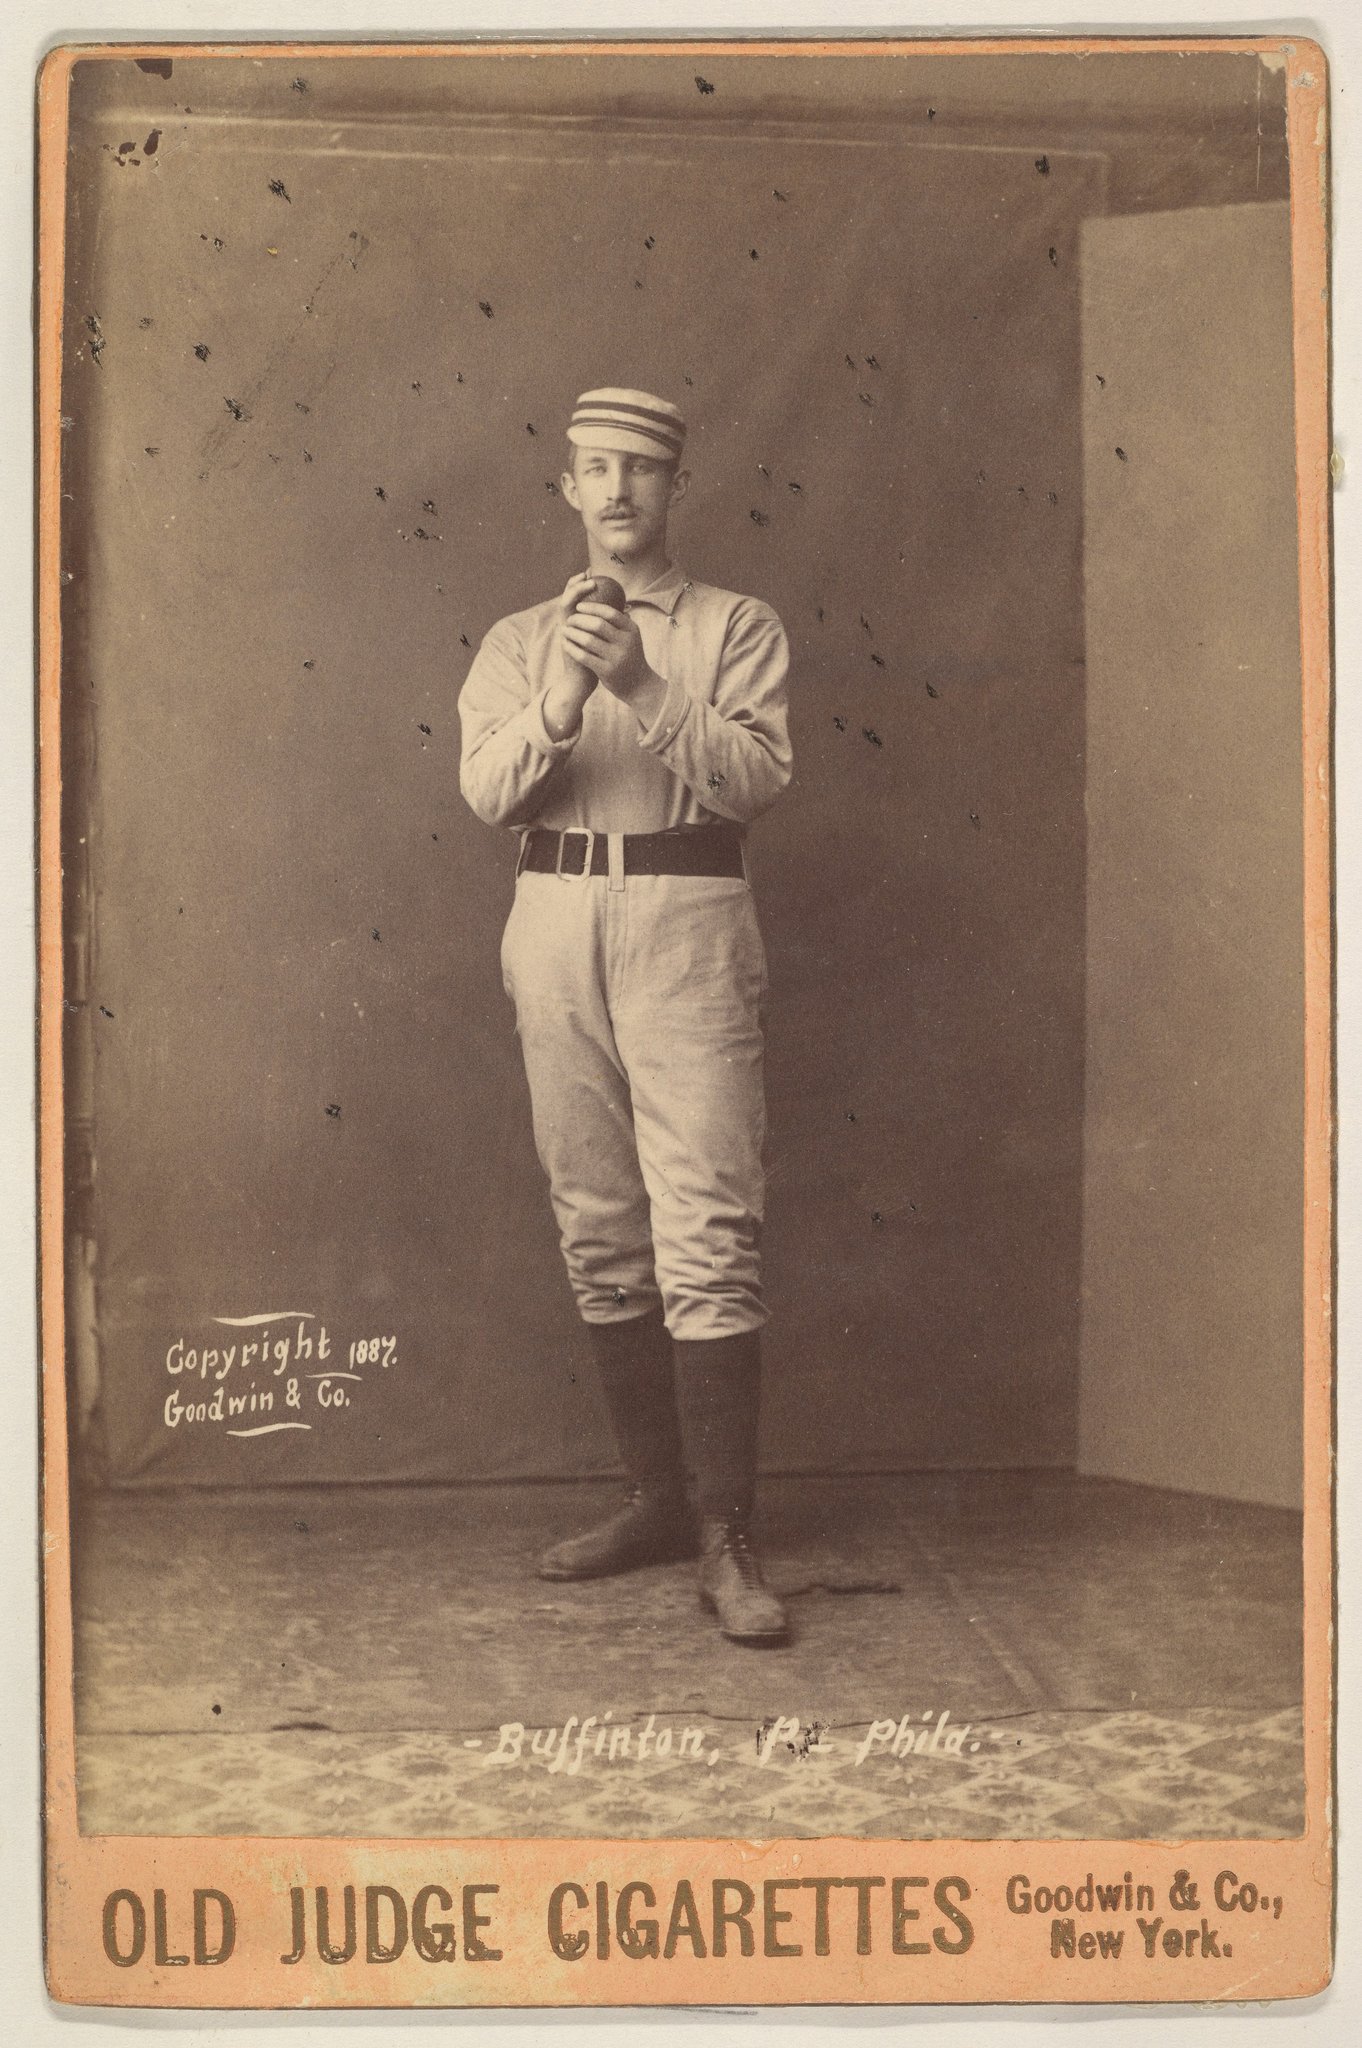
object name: baseball card, photograph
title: Buffinton, Pitcher, Philadelphia, from the series Old Judge Cigarettes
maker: goodwin & company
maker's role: publisher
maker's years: 1850-1950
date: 1887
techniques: albumen silver print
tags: men,portraits,baseball,athletes